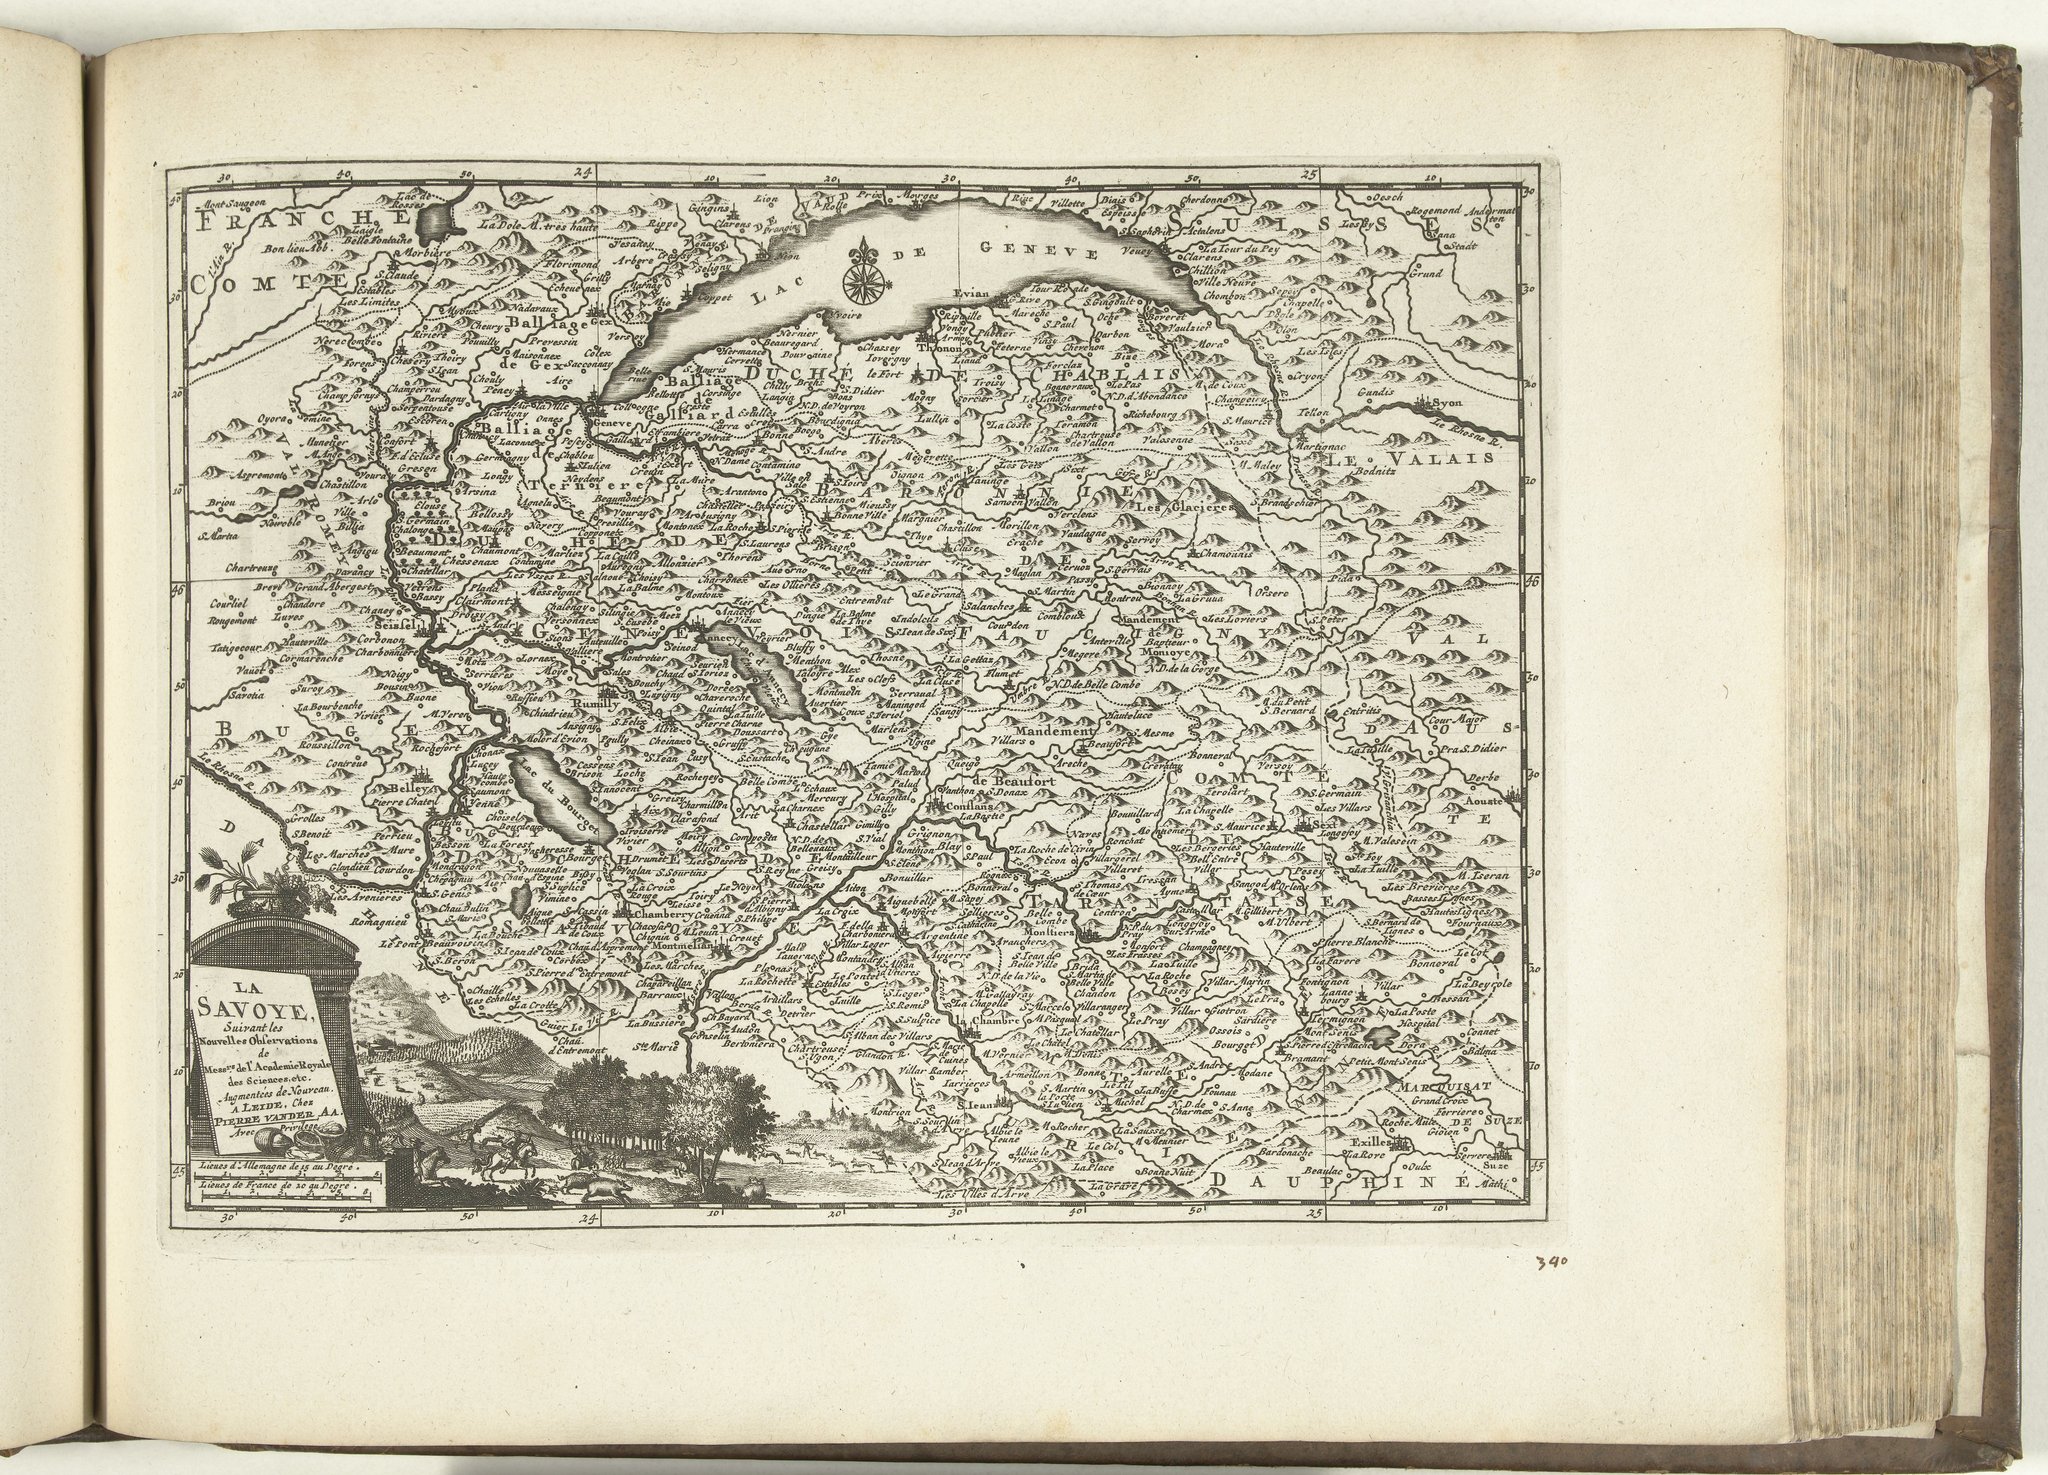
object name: map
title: Kaart van Savoye, 1726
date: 1726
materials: paper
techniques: engraving, etching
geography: northern netherlands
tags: maps of separate countries or regions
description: Kaart van Savoye. Plaat nr. 340 in deel XIV van het prentwerk: Les Forces de l'Europe, Asie, Afrique et Amerique ... Comme aussi les Cartes des Côtes de France et d'Espagne uit 1726, dit tweede deel met 271 met de hand genummerde platen van vermaarde sterke steden en vestingen in het kader van de Spaanse Successieoorlog 1701-1713. Voor het merendeel zijn deze platen gekopieerd naar de anonieme Franse platen van vermaarde sterke steden en vestingen: in Les forces de l'Europe en in: Le theatre de la guerre, dans les Pays-Bas, beide oorspronkelijk uitgegeven door Nicolas de Fer te Parijs (1693-1697) in het kader van de Negenjarige Oorlog. Titel en opschriften in het Frans.